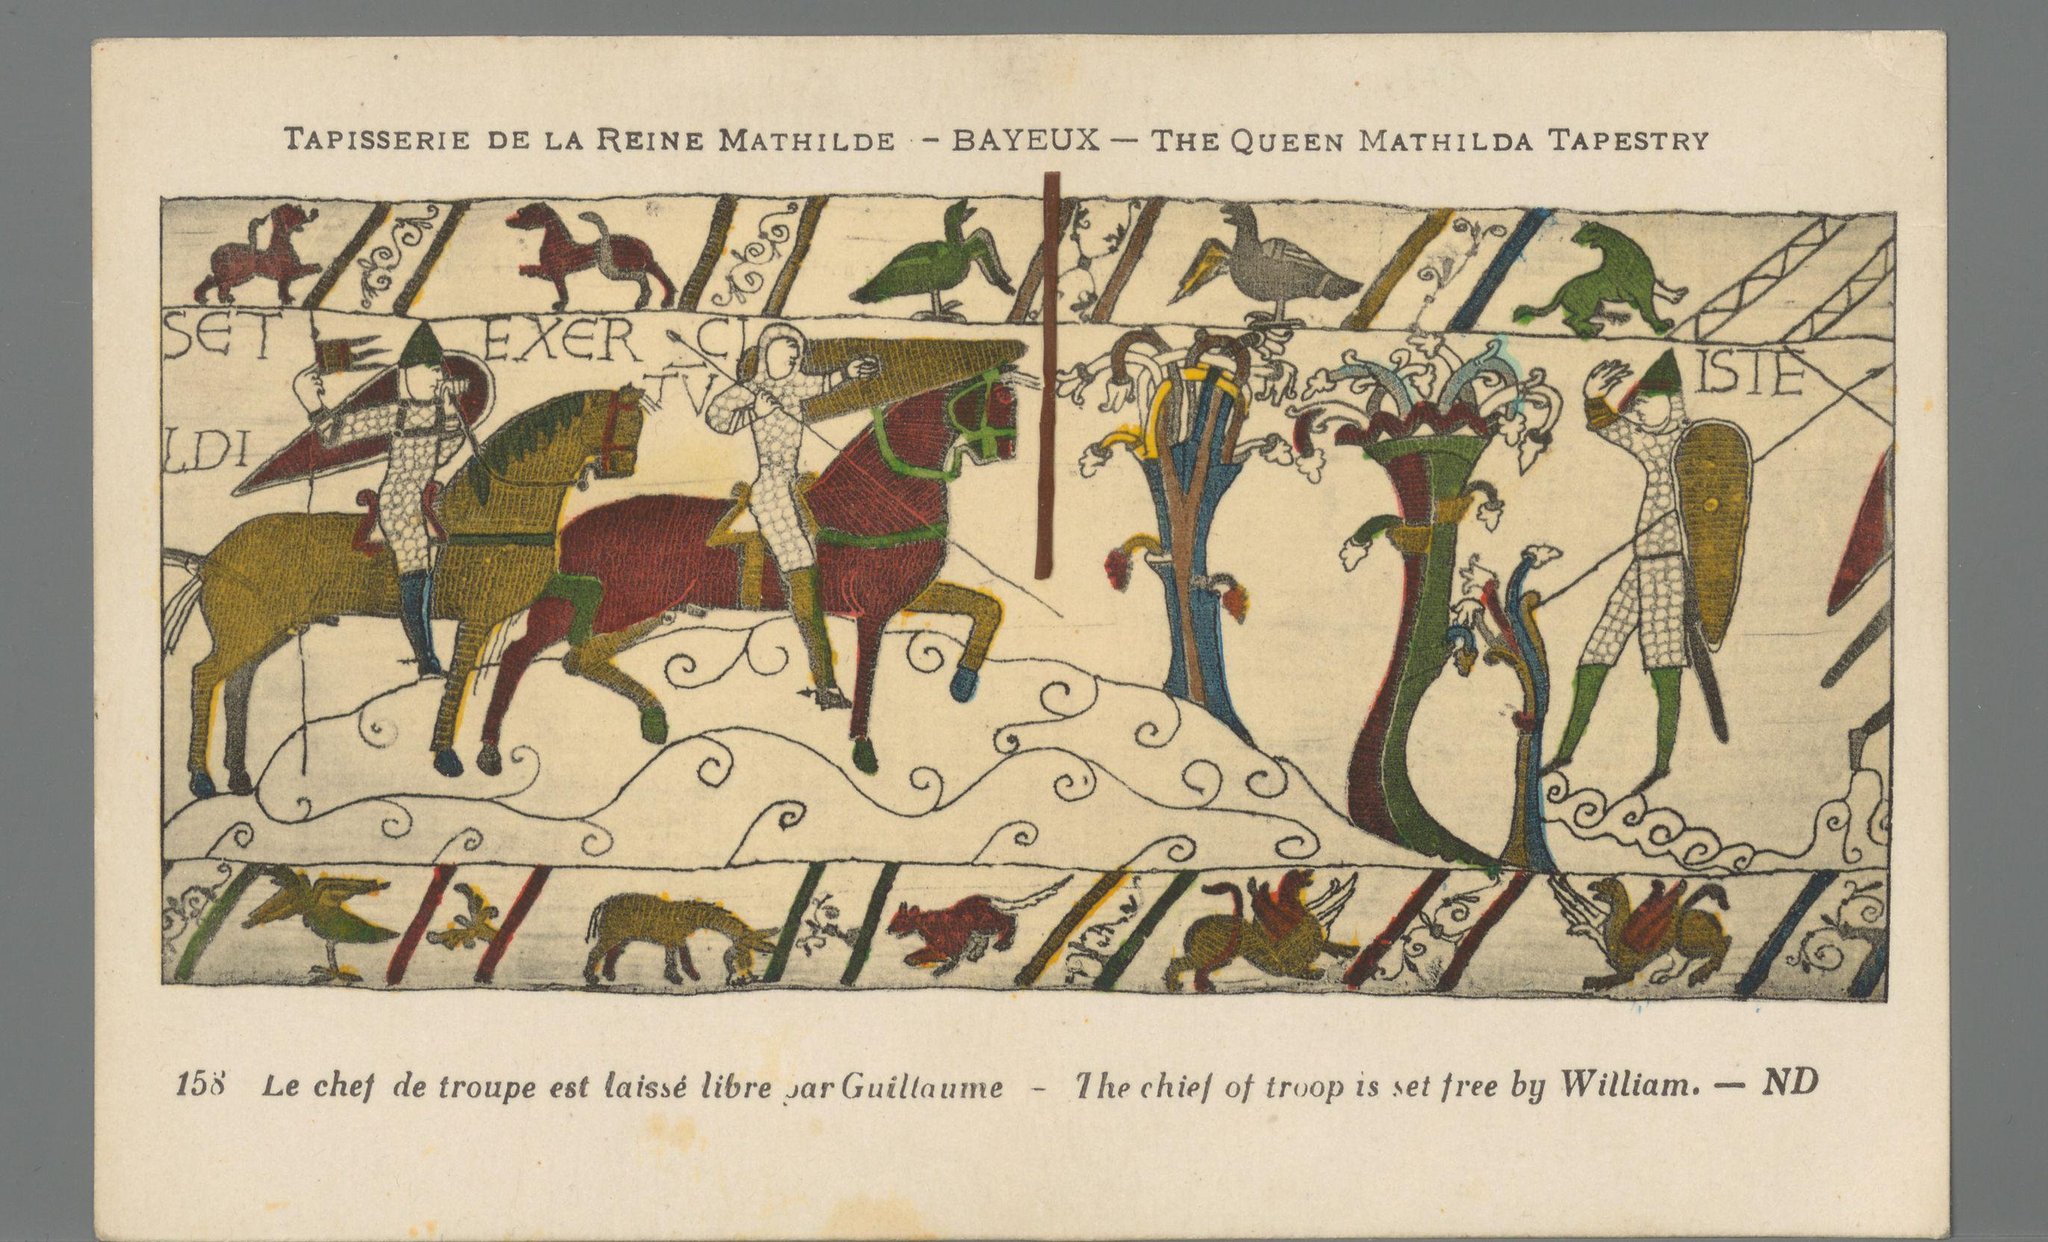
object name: ansichtkaart, prentbriefkaart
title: Tapisserie de la Reine Mathilde - Bayeux / The Queen Mathilda tapestry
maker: Anonymous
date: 1903-1932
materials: cardboard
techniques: photograph, lithograph, writing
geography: paris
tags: permanent exhibition, museum, tapestry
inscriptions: collector's mark: ‘AFE v S’